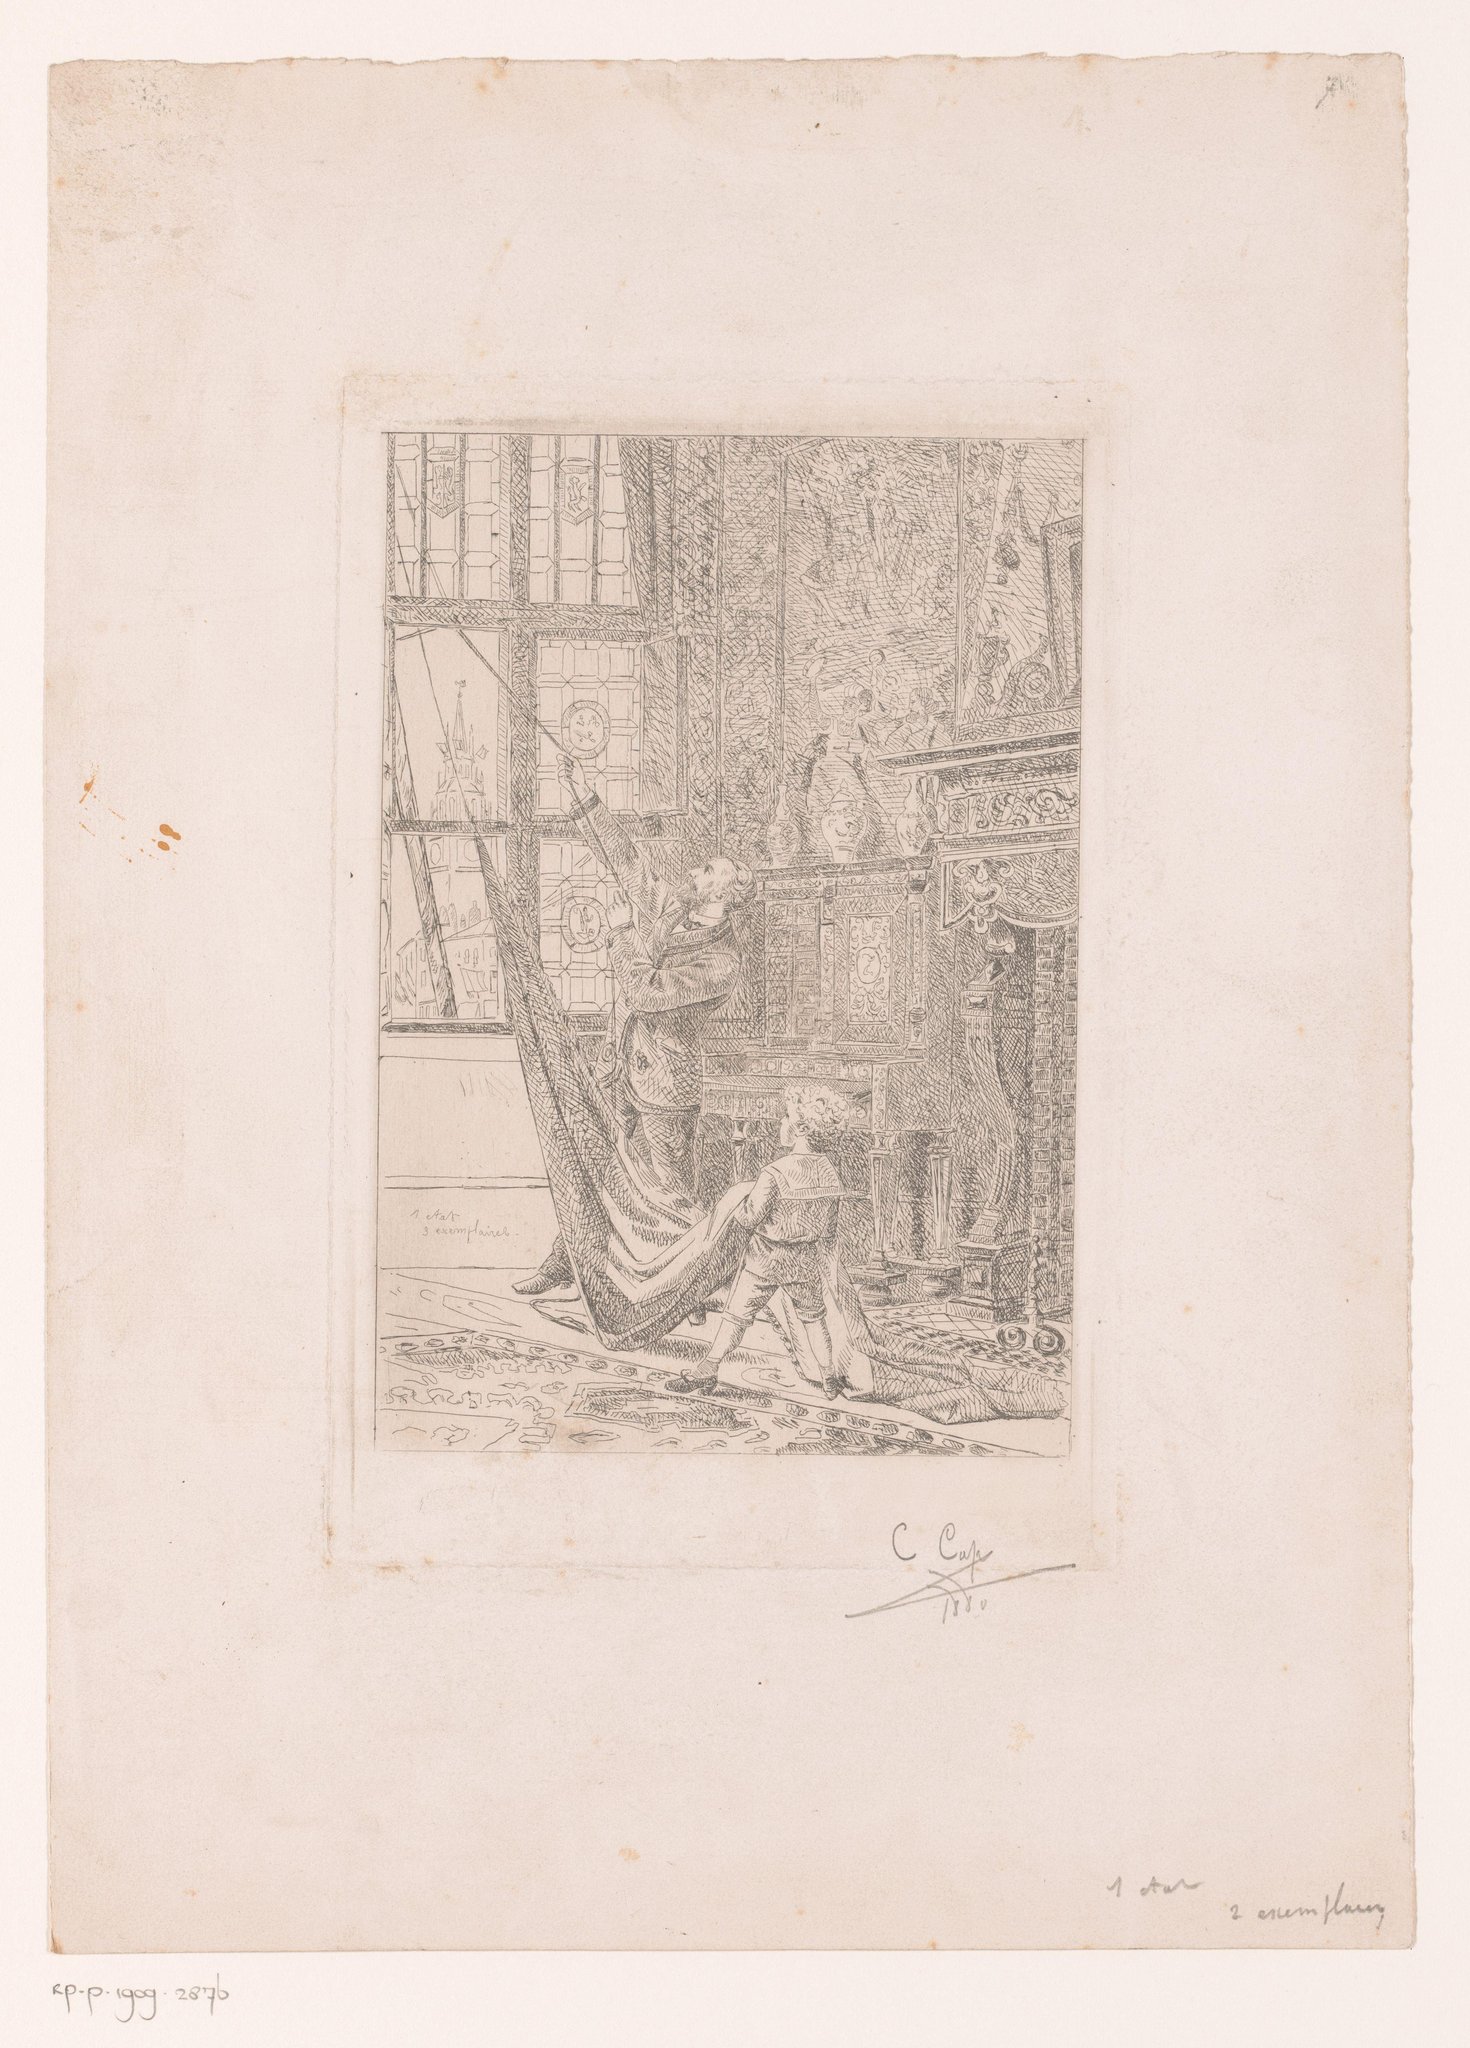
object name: print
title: Patriotisme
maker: constant aimé marie cap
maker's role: print maker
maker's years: 1842-1915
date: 1880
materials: paper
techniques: etching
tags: patriotism, flag display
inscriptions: collector's mark: Lugt 2228, annotation: ‘1 etat 2 exemplaires’